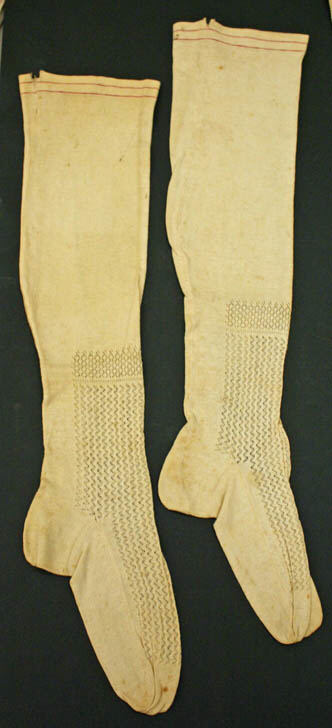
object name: stocking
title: Stockings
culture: american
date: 1860-1879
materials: cotton